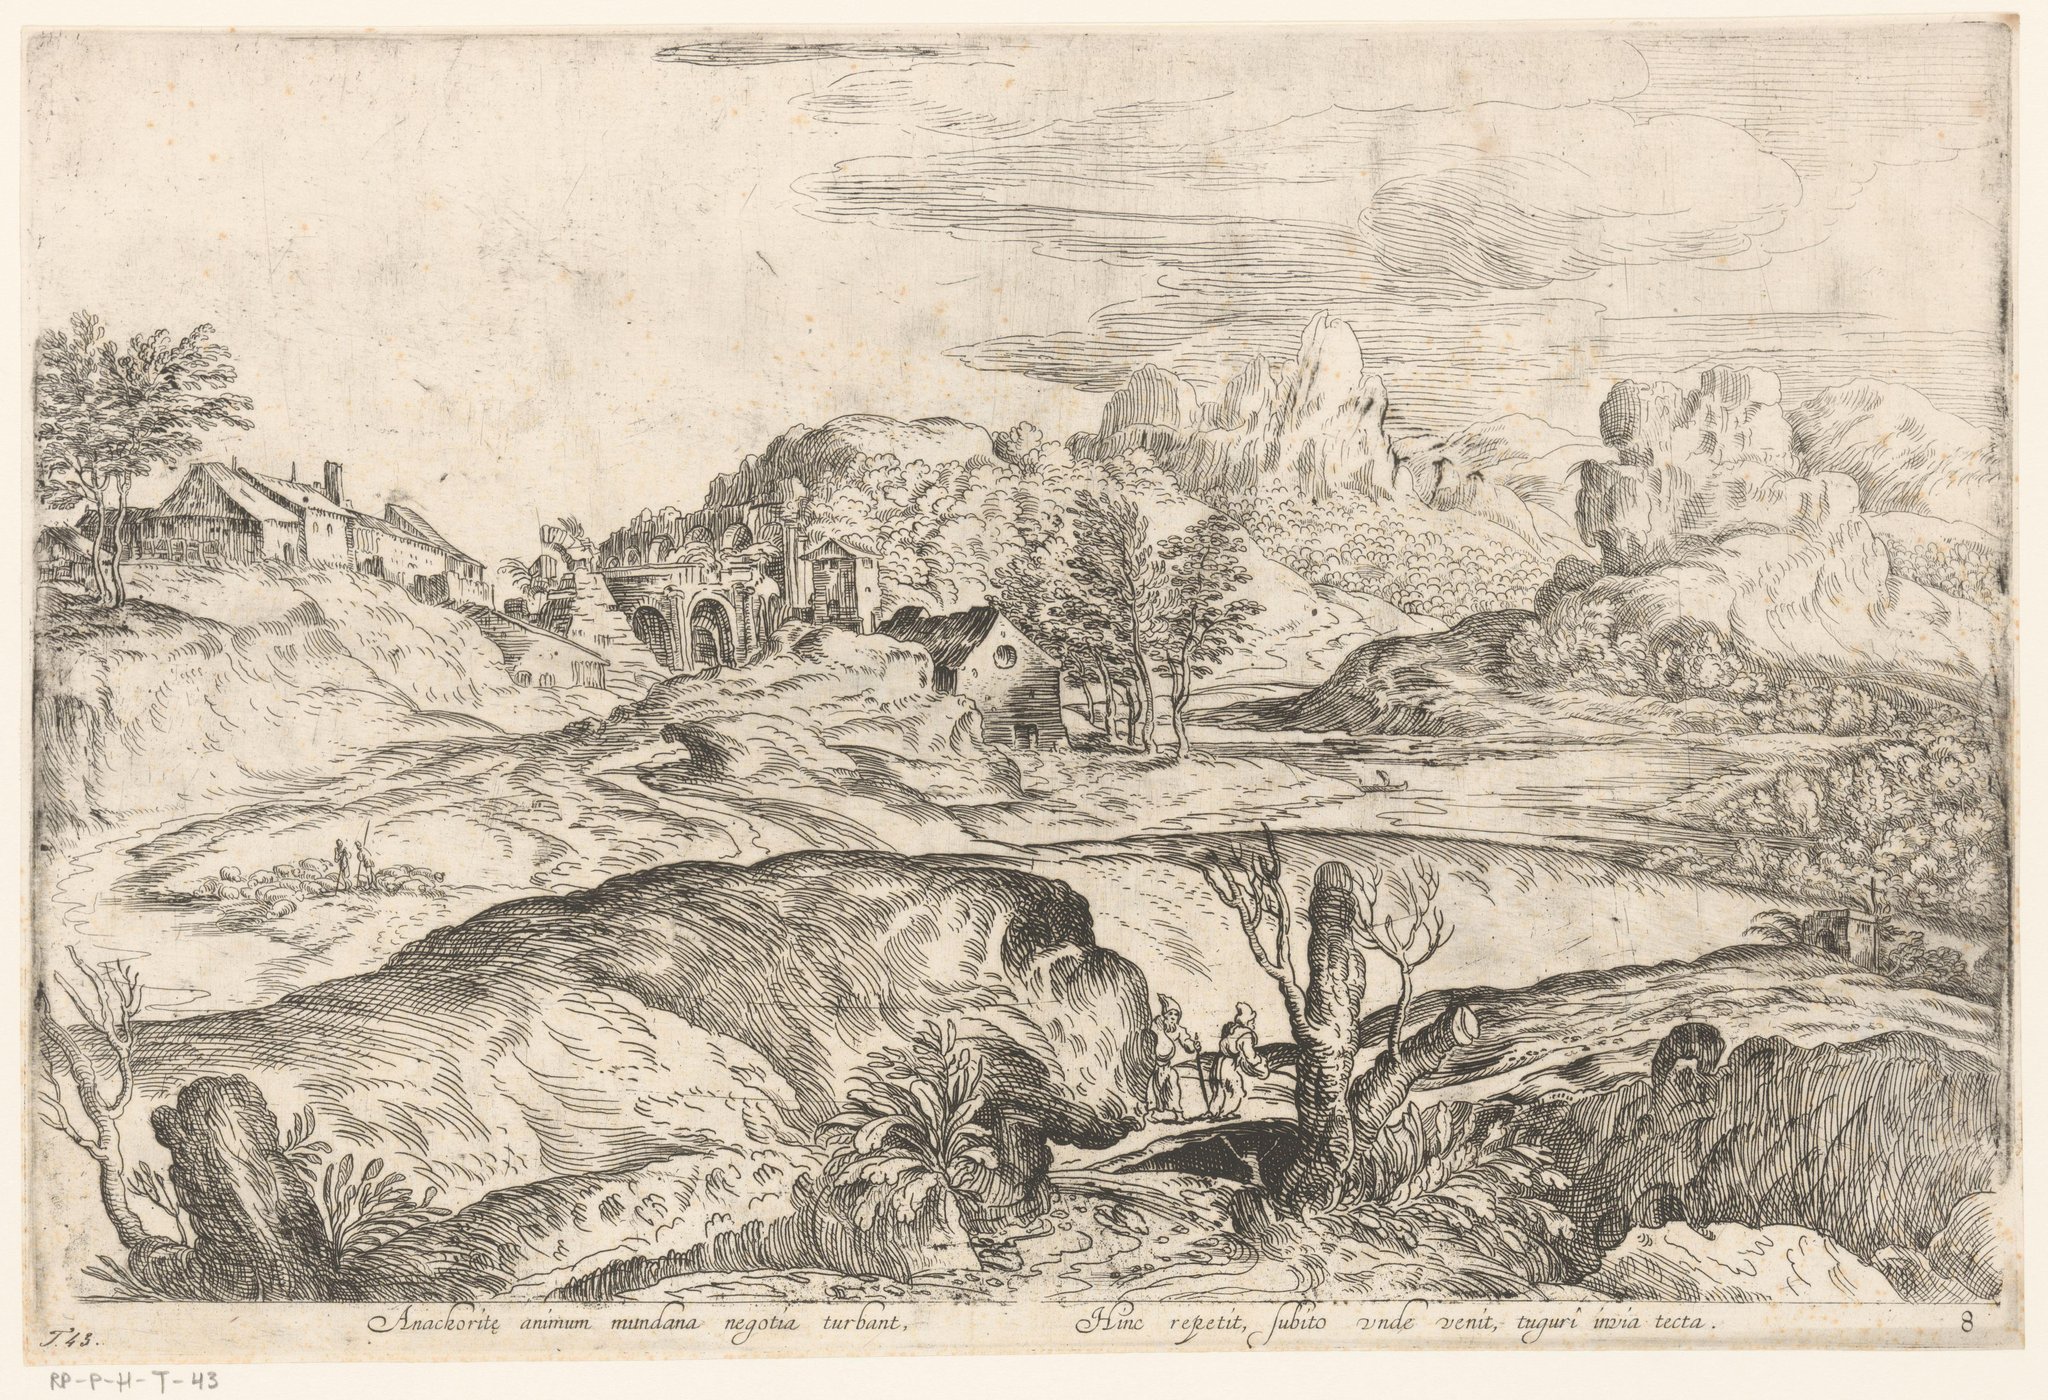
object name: print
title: Landschappen naar Domenico Campagnola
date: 1600-1699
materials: paper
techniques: etching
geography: italy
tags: landscapes, pilgrim(s), pilgrimage, pilgrim(s) under way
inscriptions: collector's mark: ‘Hinloopen’, number: ‘T. 43.’, collector's mark: Lugt 11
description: Heuvellandschap met links een dorp. Op de voorgrond rechts lopen twee pelgrims. Titel in het Latijn in ondermarge. Genummerd rechtsonder: 8.